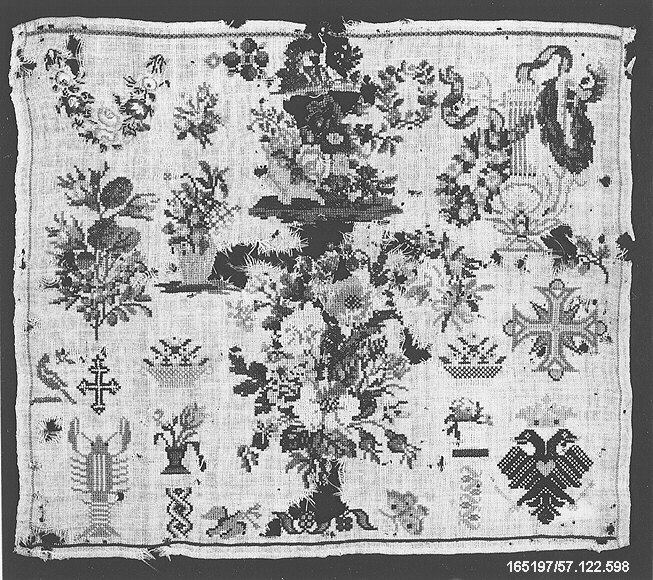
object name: sampler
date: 1801-1900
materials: canvas, cotton, wool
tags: scorpions,flowers,cross,insignia